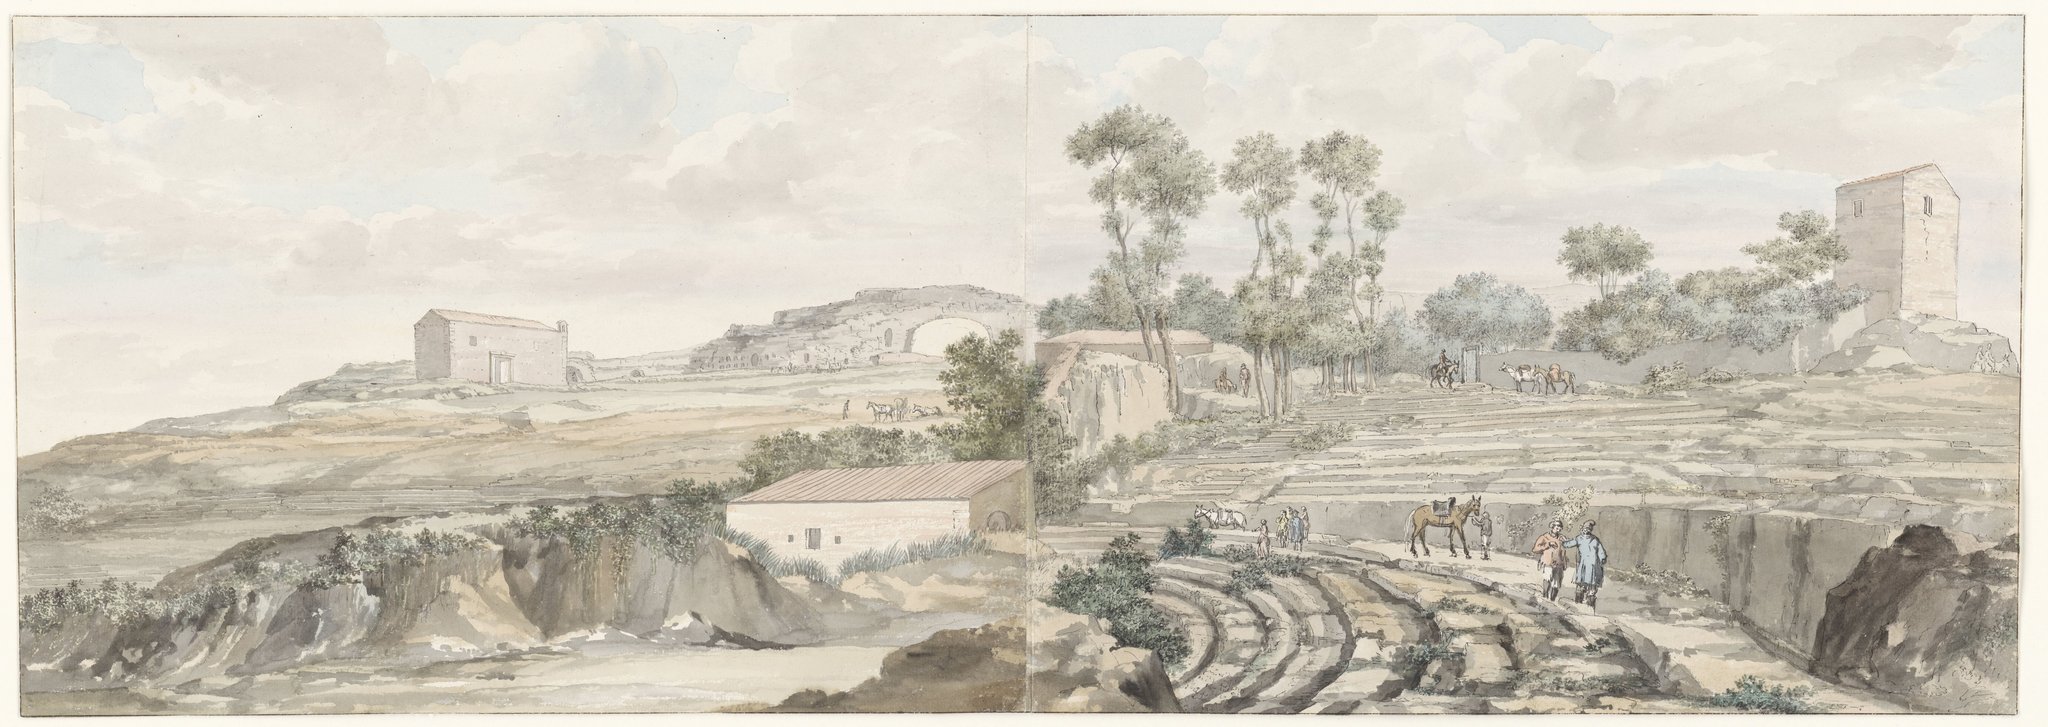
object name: drawing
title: Vue de l'intérieur, et des gradins du Théâtre de Syracuse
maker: louis ducros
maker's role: draughtsman, print maker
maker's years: 1748-1810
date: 1778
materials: chalk, paper, watercolor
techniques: brush, pen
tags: city-view, and landscape with man-made constructions, theatre (building)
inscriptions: number: ‘No 192 Vue de l'intérieur, et des gradins du Théâtre de Syracuse’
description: Tekening uit het album 'Voyage en Italie, en Sicile et à Malte', 1778.